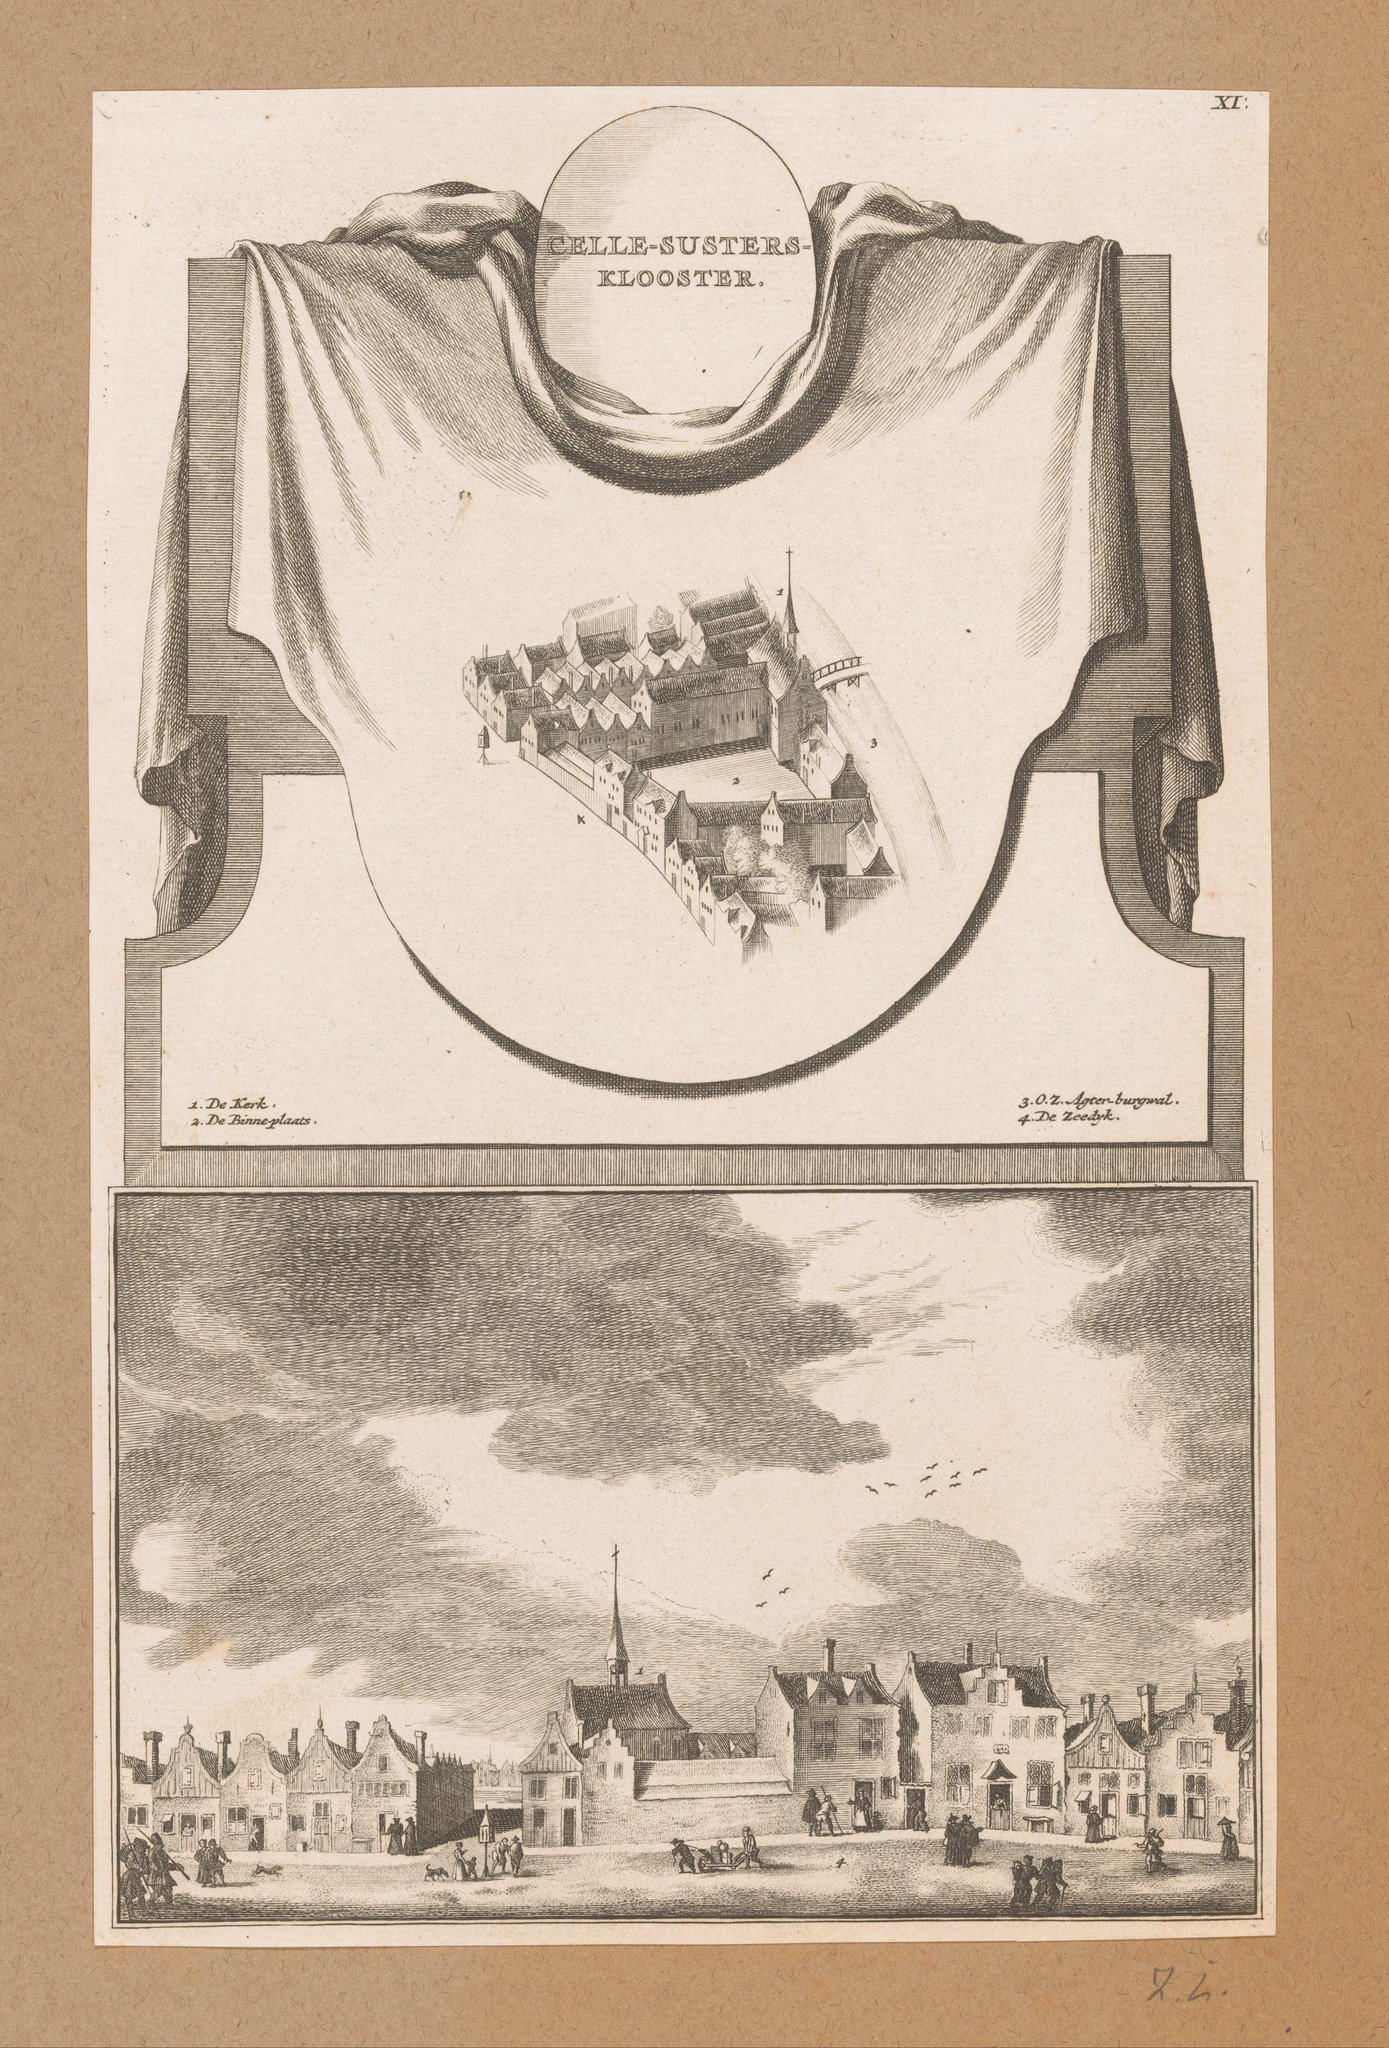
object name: book illustration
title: Gezichten op het Cellezustersklooster te Amsterdam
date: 1760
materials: paper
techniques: engraving, etching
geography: amsterdam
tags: abbey, monastery, convent ~ roman catholic church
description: Prent ook gebruikt in: Wagenaar, Jan. Amsterdam, in zyne opkomst, aanwas, geschiedenissen (…). 3 dln. [folio-uitgave]. Amsterdam: Isaak Tirion en Yntema & Tieboel, 1760-1767, dl. 1 (Isaac Tirion, 1760). Zie RP-P-AO-24X-22 voor proefdruk. Dat de prent de situatie rond 1544 weergeeft gaat terug op het feit dat voor het maken van deze en andere prenten van kloosters en kerken van voor de Alteratie (1578) is uitgegaan van de plattegrond van Cornelis Anthonisz. uit 1544 (zie RP-P-OB-70.399 en RP-P-AO-20-15).